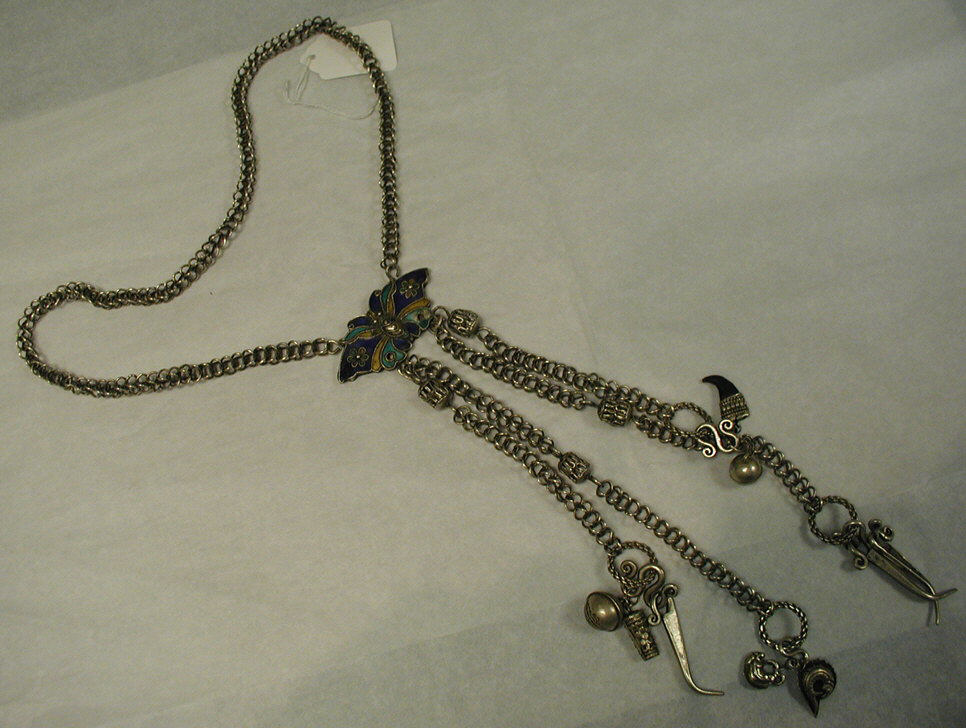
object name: necklace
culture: chinese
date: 1801-1900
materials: silver